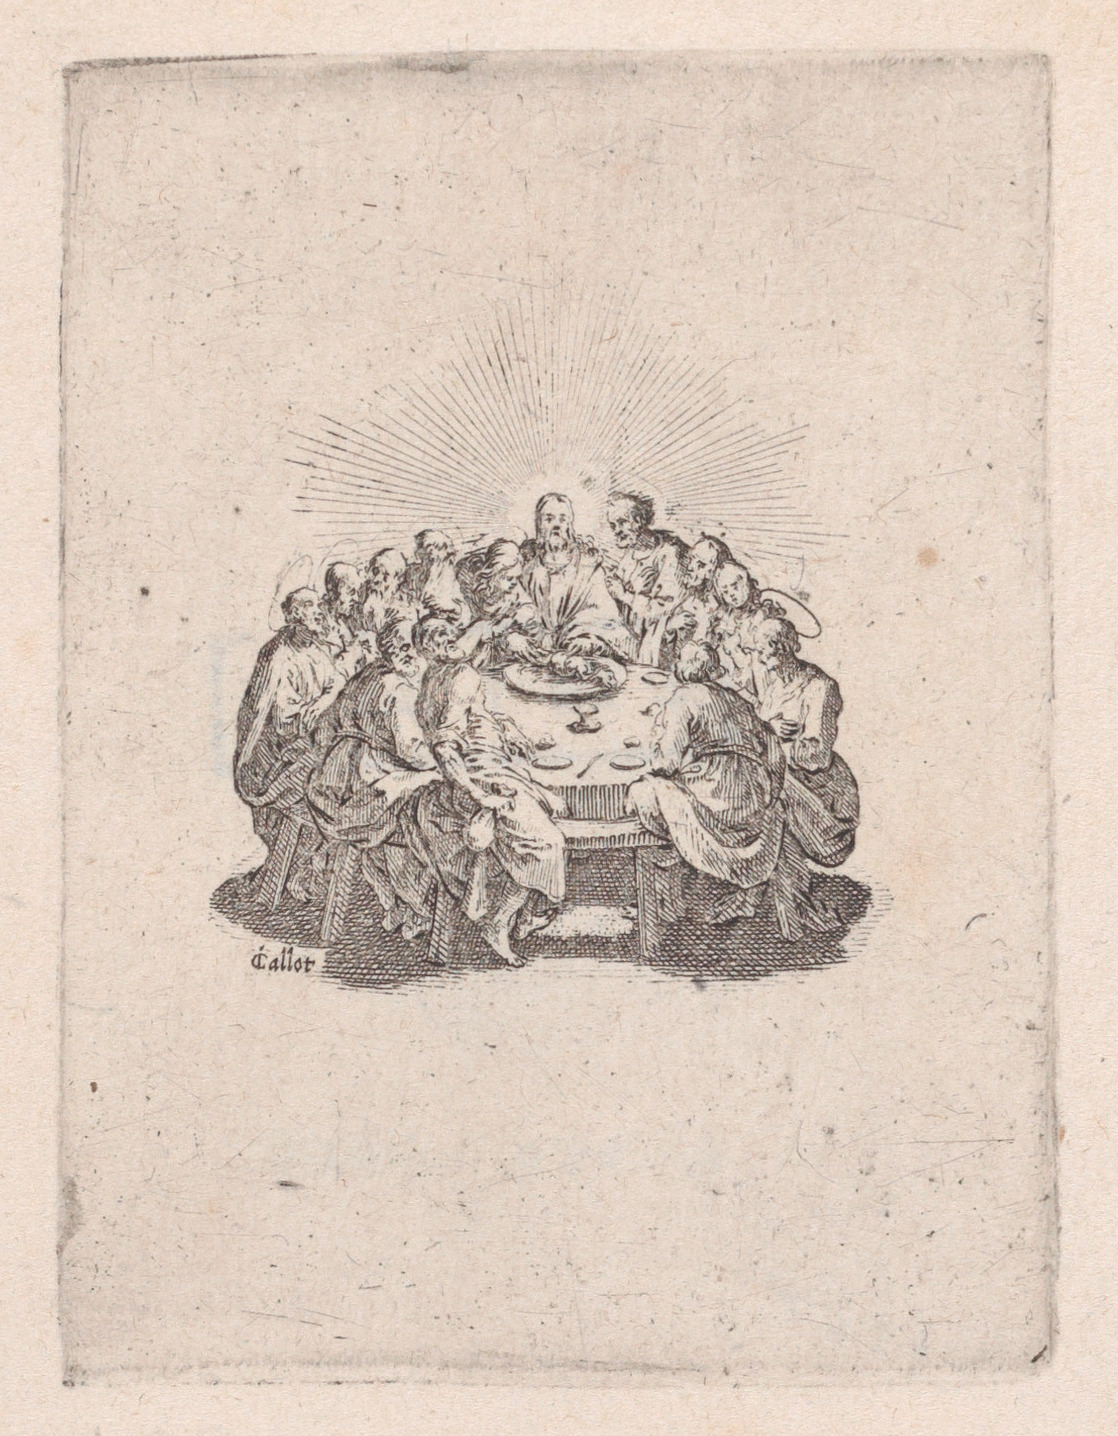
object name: print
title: Les Noces de Cana (The Wedding at Cana), from "Les Quatre Banquets" (The Four Feasts)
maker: jacques callot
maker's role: artist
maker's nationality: french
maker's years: 1592-1635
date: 1625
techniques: engraving, etching